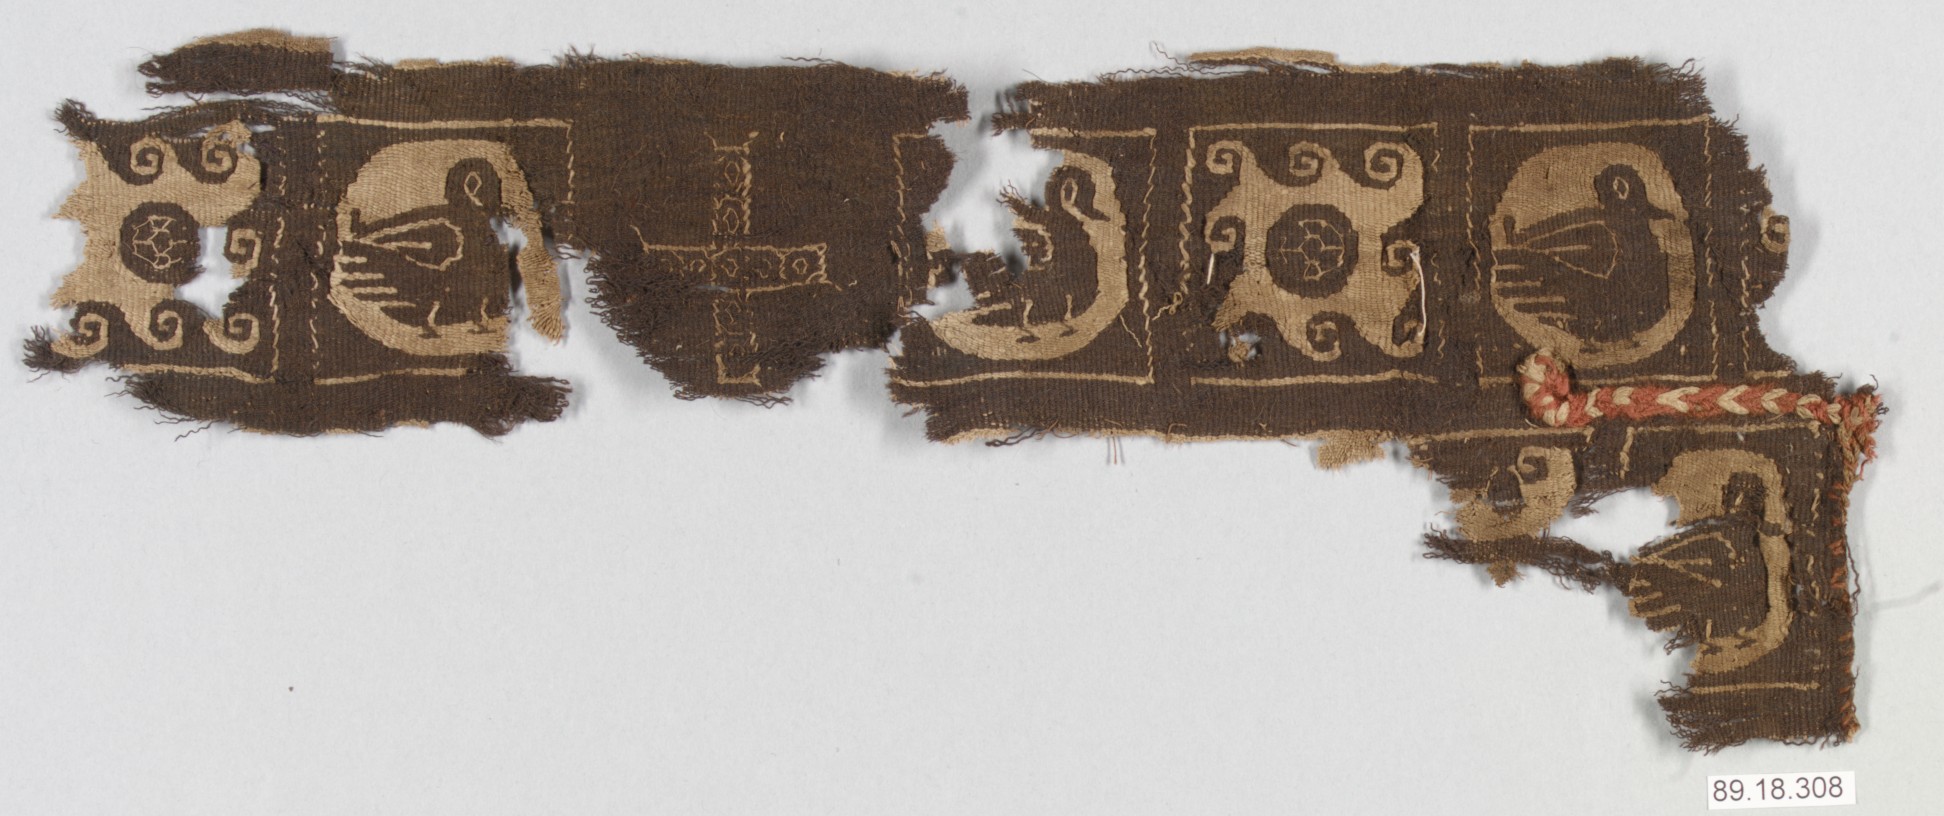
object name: textile fragment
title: Band with Cross and Short-legged Aquatic Birds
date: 401-700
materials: linen, wool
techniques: weave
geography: egypt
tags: birds